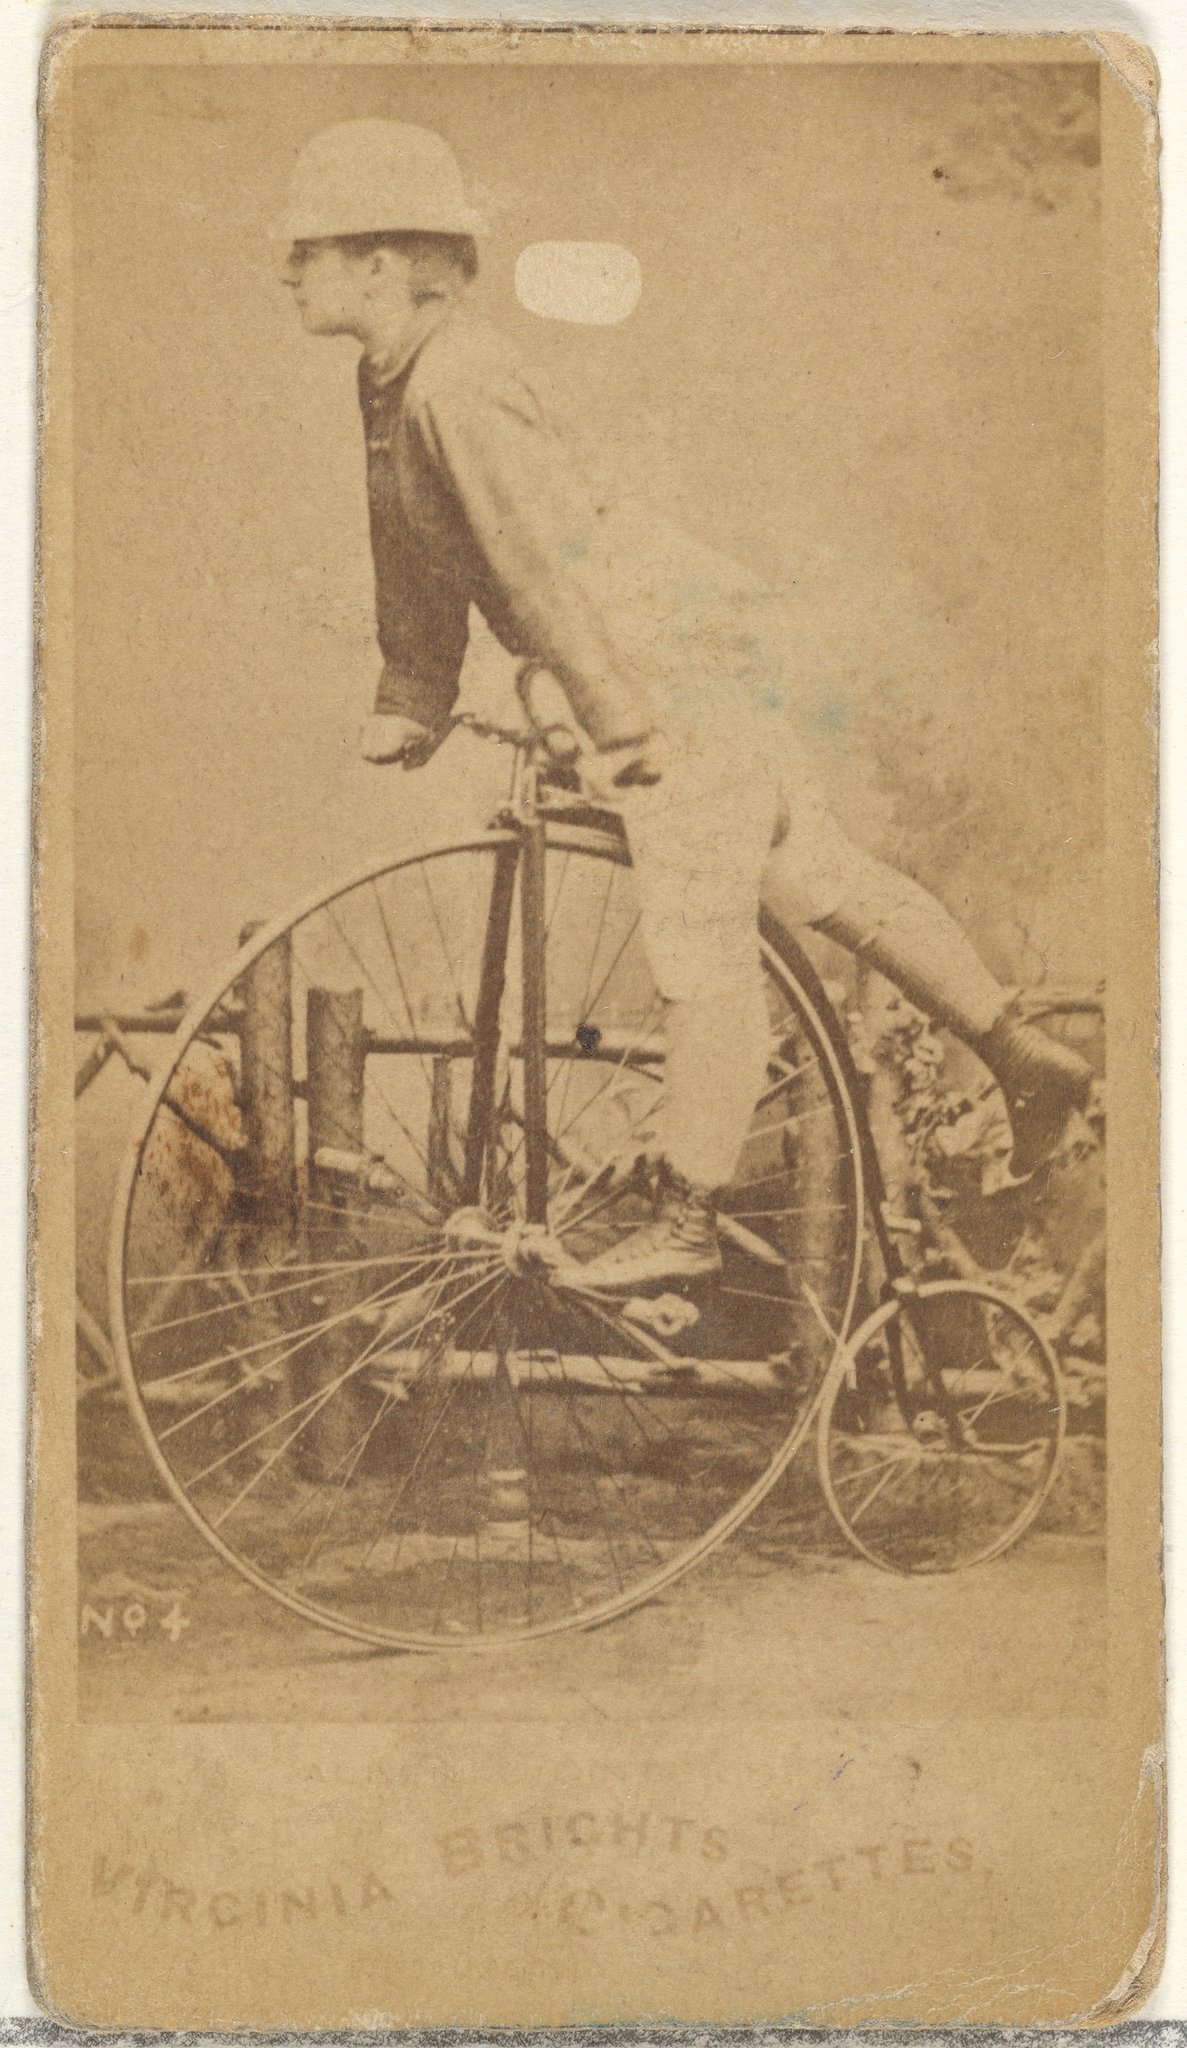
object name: photograph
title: Card 4, from the Girl Cyclists series (N49) for Virginia Brights Cigarettes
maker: allen & ginter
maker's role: publisher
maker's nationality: american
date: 1887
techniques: albumen silver print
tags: girls,bicycles